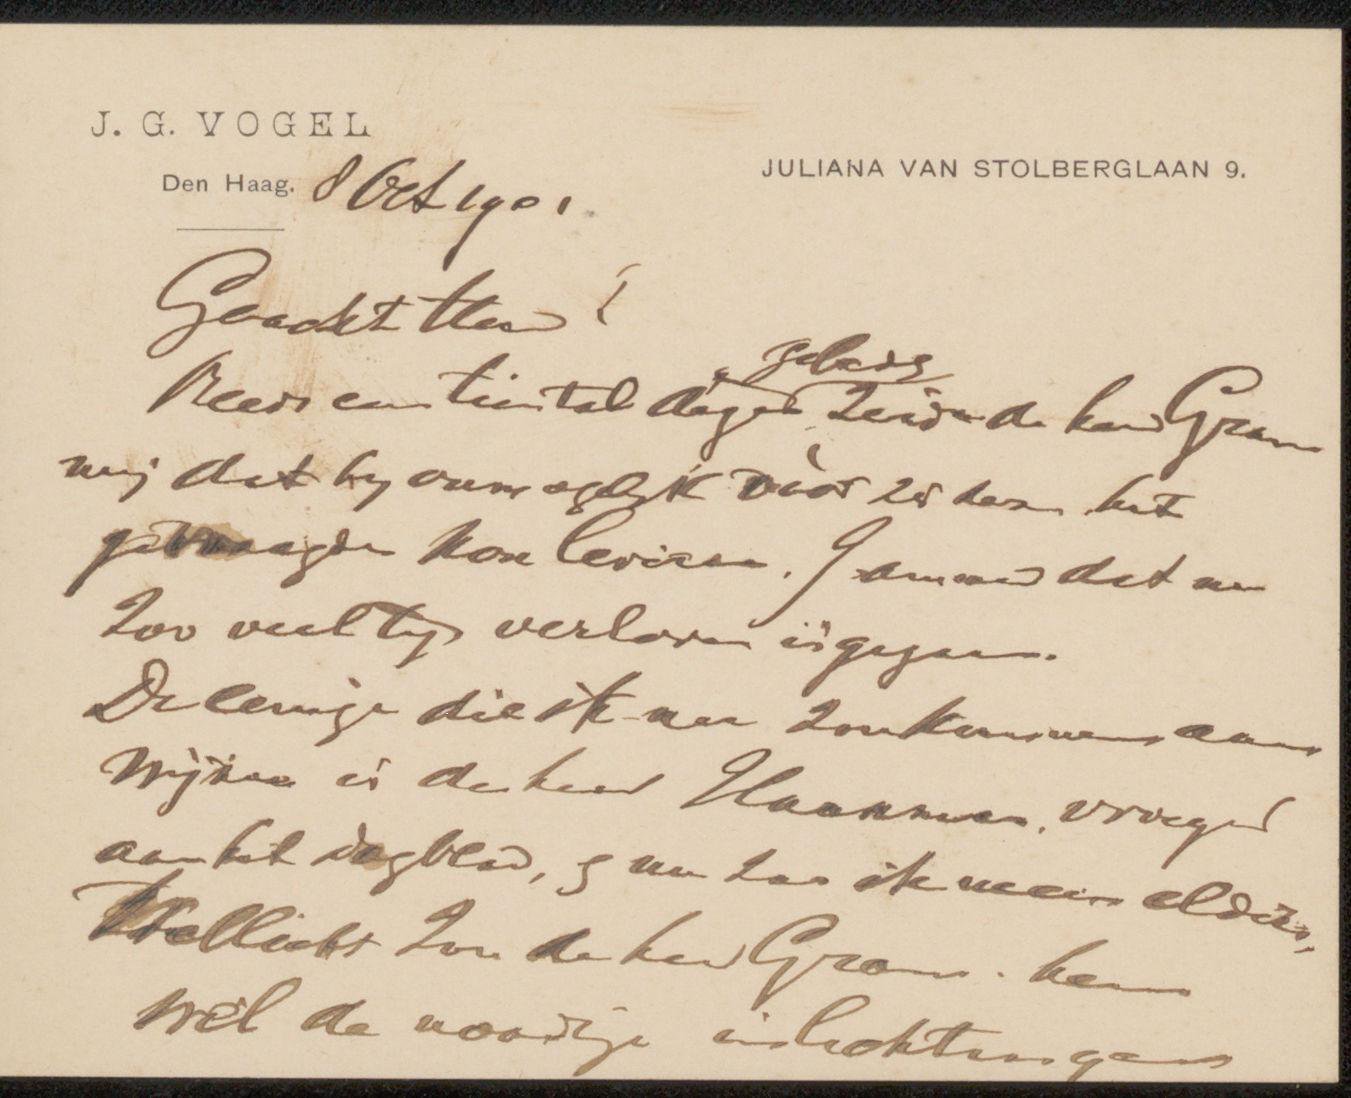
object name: letter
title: Brief aan Philip Zilcken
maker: margaretha roosenboom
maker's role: draughtsman, painter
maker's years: 1843-1896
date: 1901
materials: cardboard, ink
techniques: pen, printing, writing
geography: the hague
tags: johan gram, delft, pieter anne haaxman, the hague, painter, draughtsman, philip zilcken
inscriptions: collector's mark: ‘RPK’